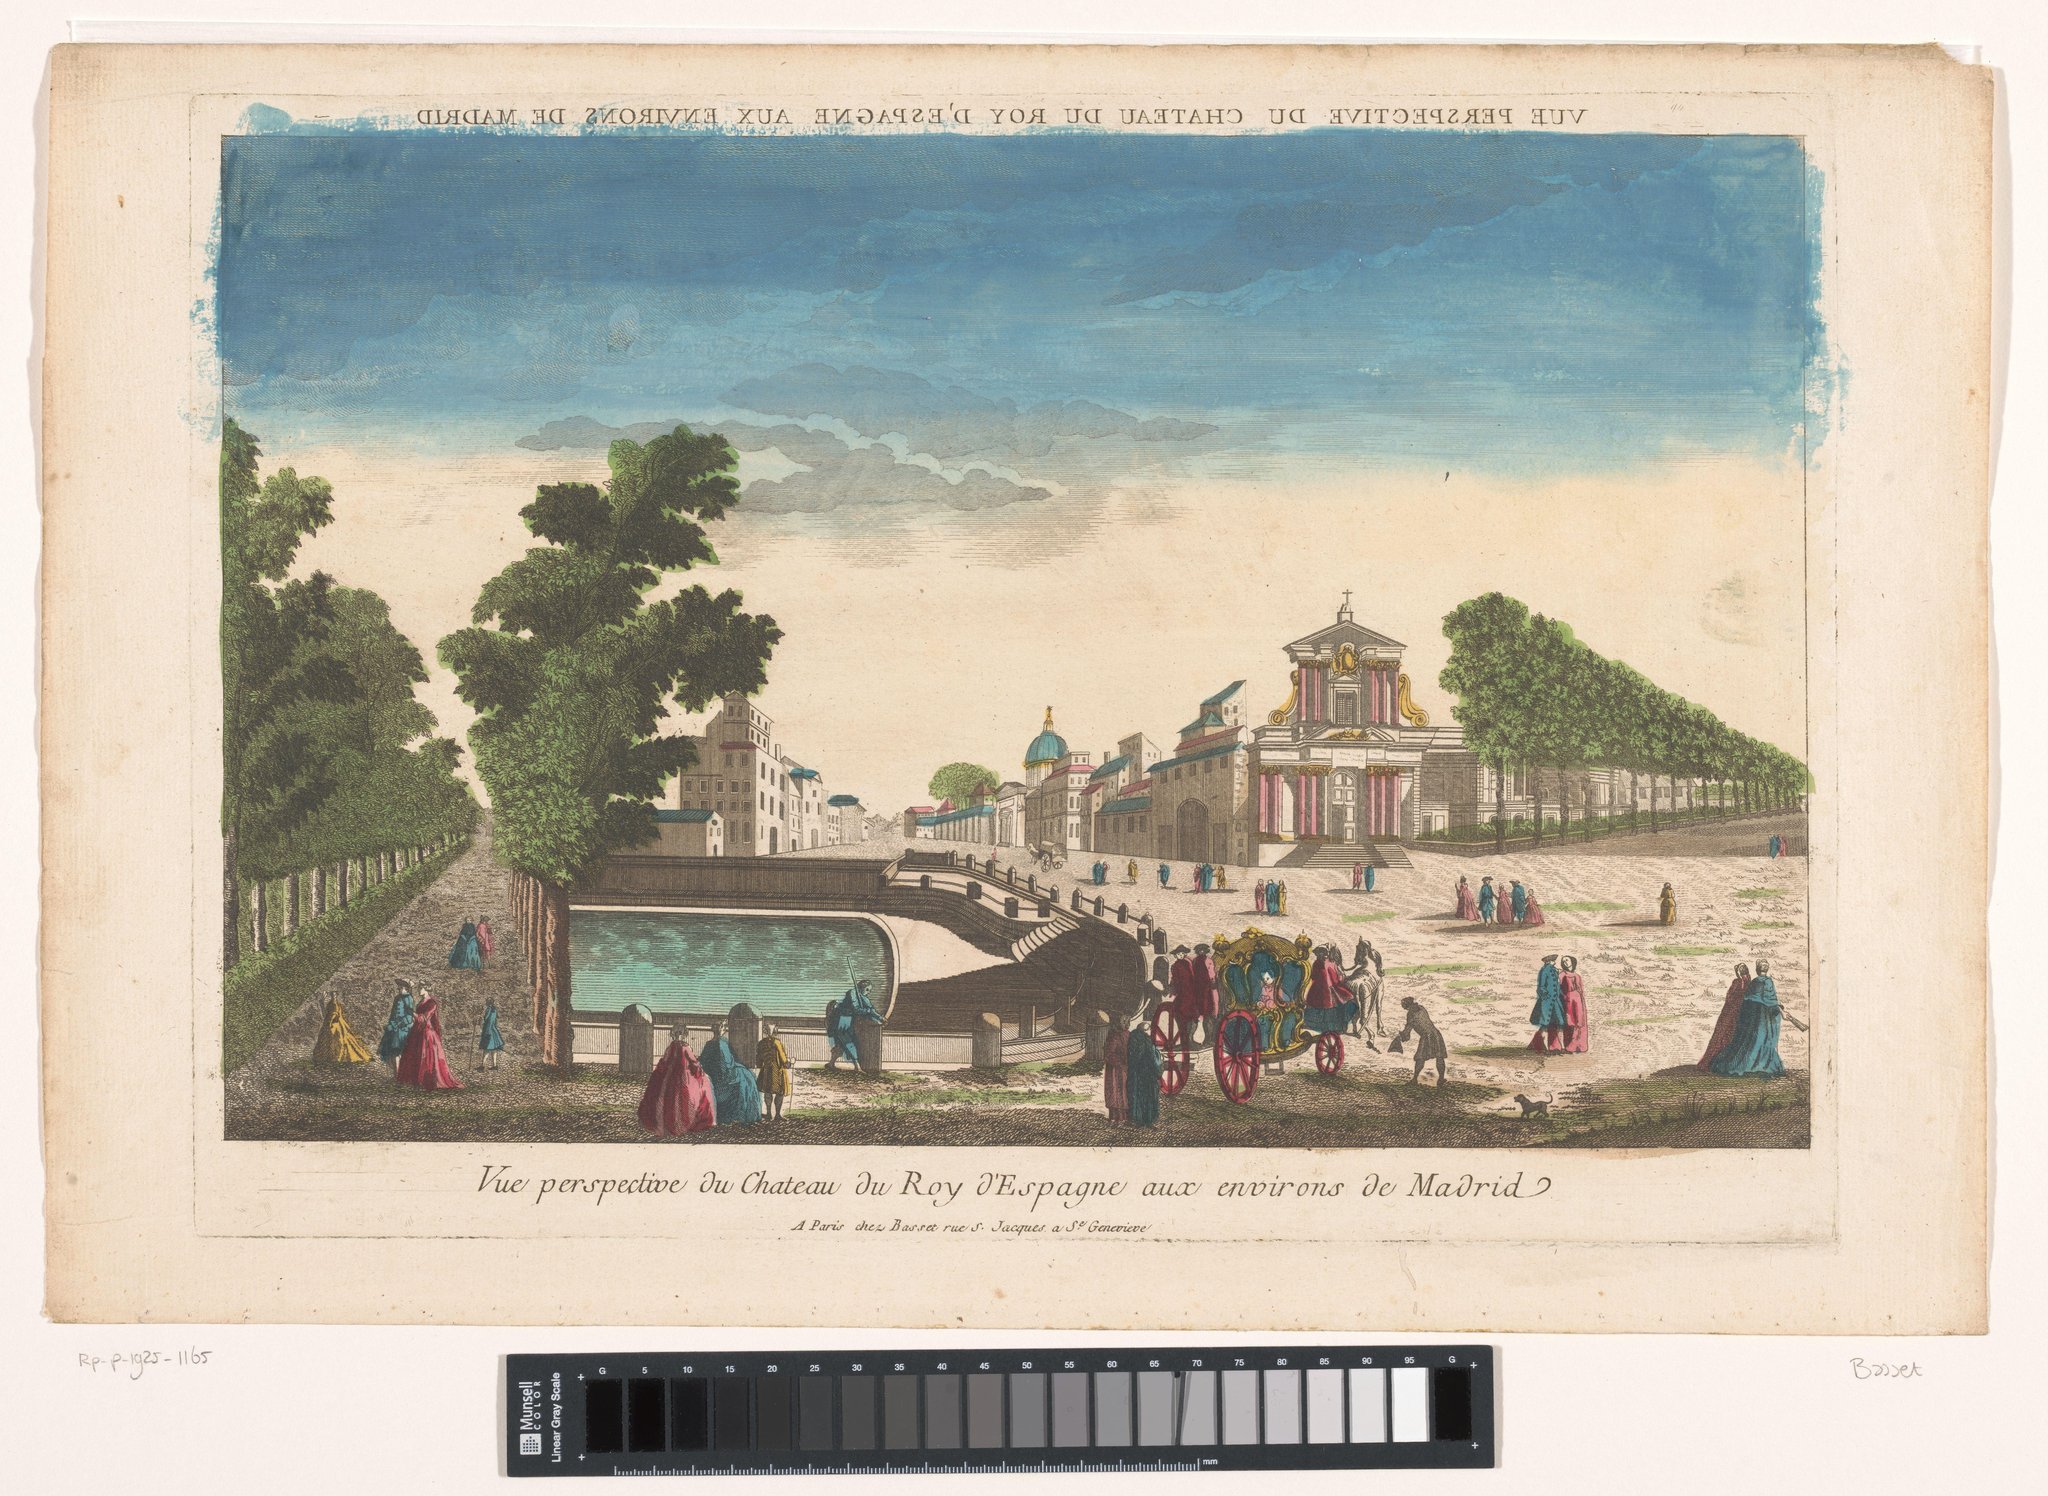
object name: print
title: Gezicht op het kasteel van de koning van Spanje in de omgeving van de stad Madrid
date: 1700-1799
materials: paper, watercolor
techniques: brush, etching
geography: paris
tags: castle, four-wheeled vehicle drawn by two animals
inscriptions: collector's mark: Lugt 2166, watermark